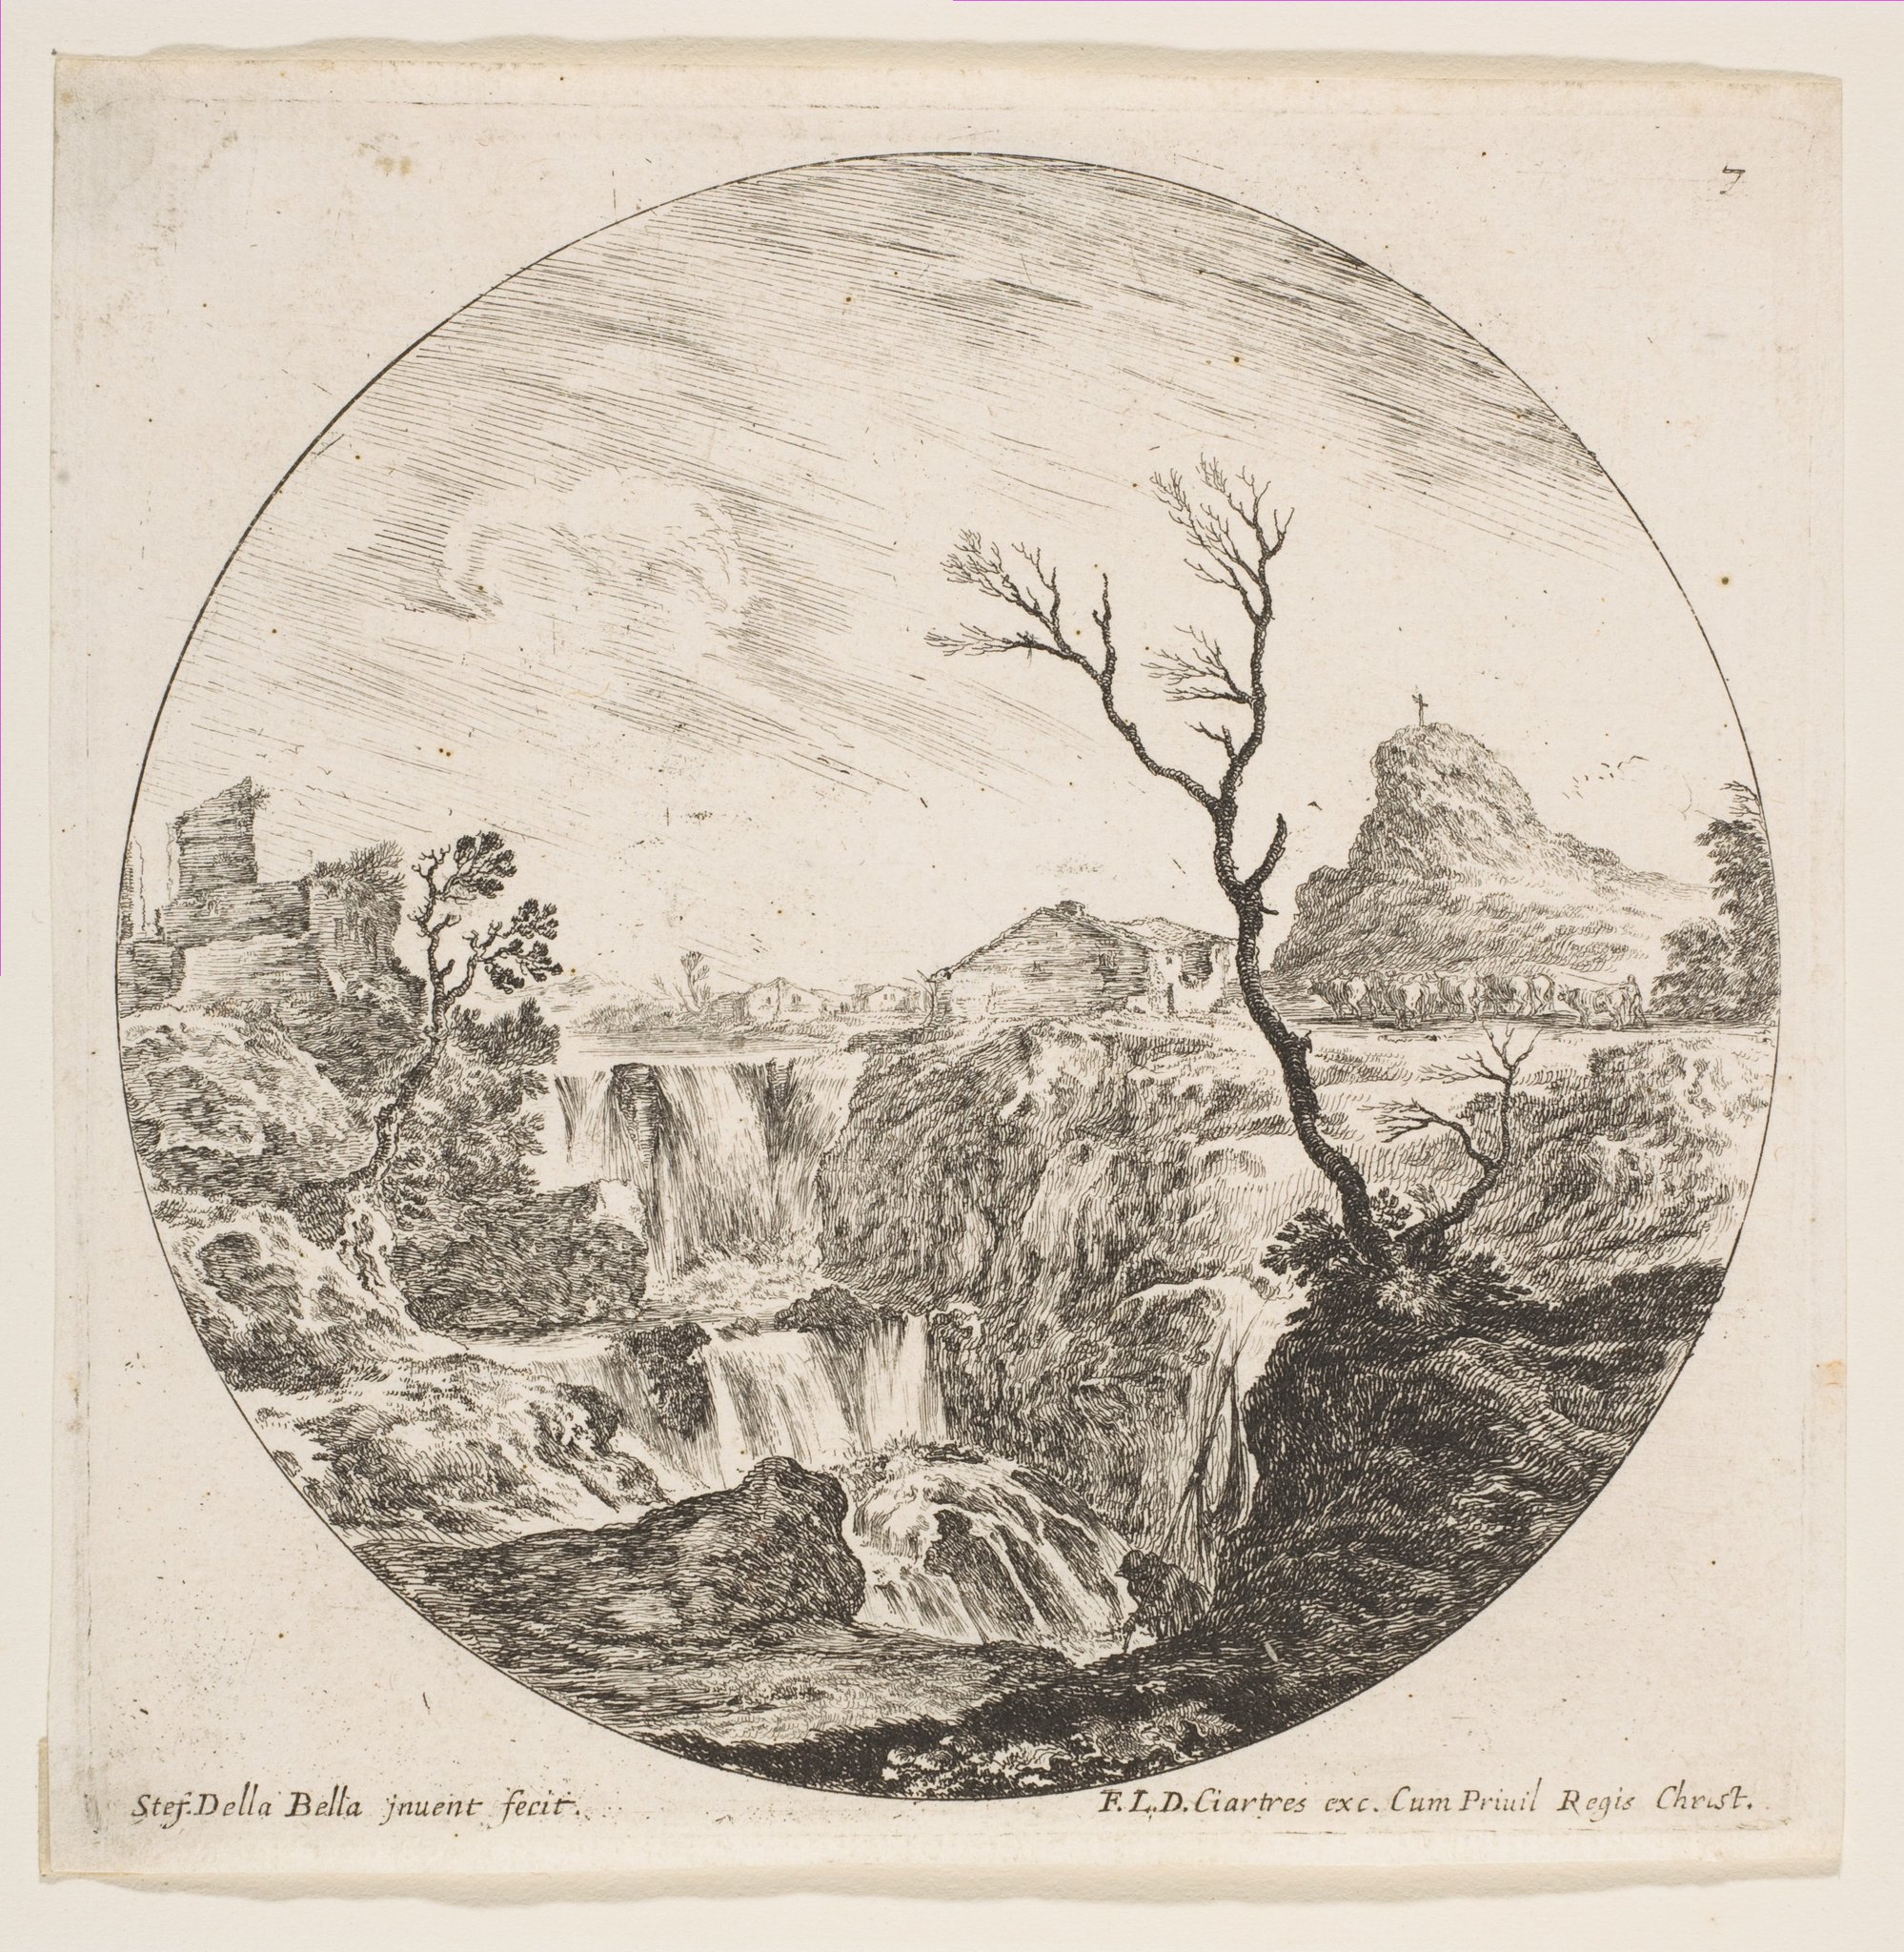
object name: print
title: A triple waterfall, a dead tree at right, a mountain and a herd of cows in the background at right, plate 7 from "Roman landscapes and ruins" (Paysages et ruines de Rome)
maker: stefano della bella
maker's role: artist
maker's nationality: italian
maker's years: 1610-1664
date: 1646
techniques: etching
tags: waterfalls,mountains,landscapes,trees